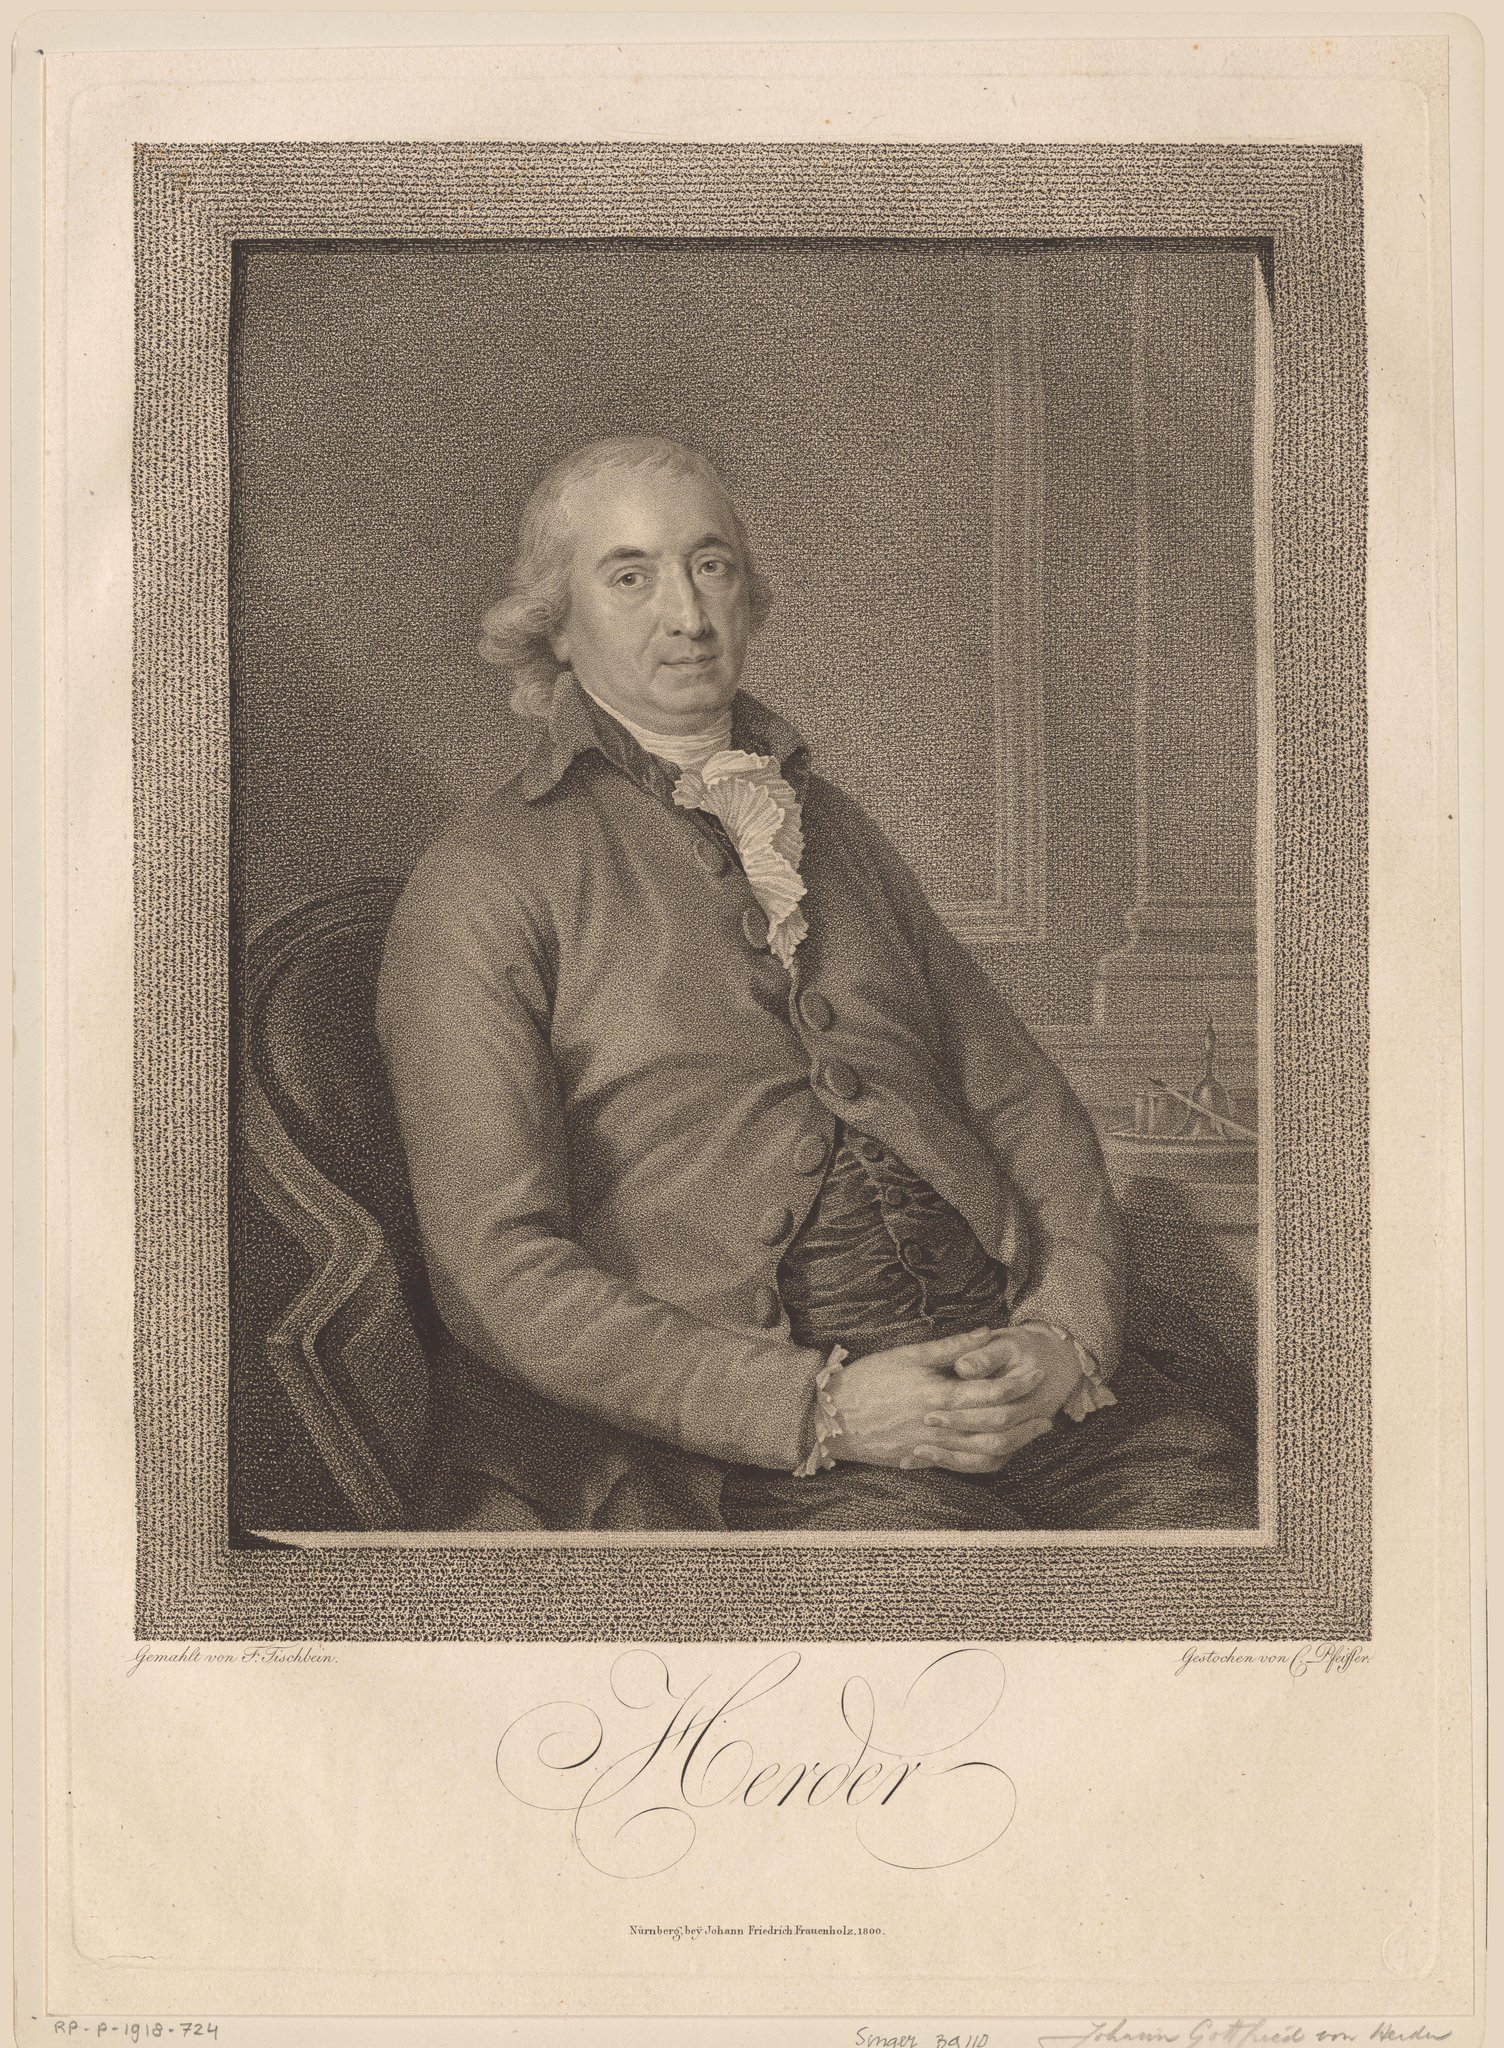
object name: print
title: Portret van Johann Gottfried von Herder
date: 1800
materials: paper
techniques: engraving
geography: nuremberg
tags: historical persons, writer, poet, author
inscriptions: collector's mark: Lugt 2233